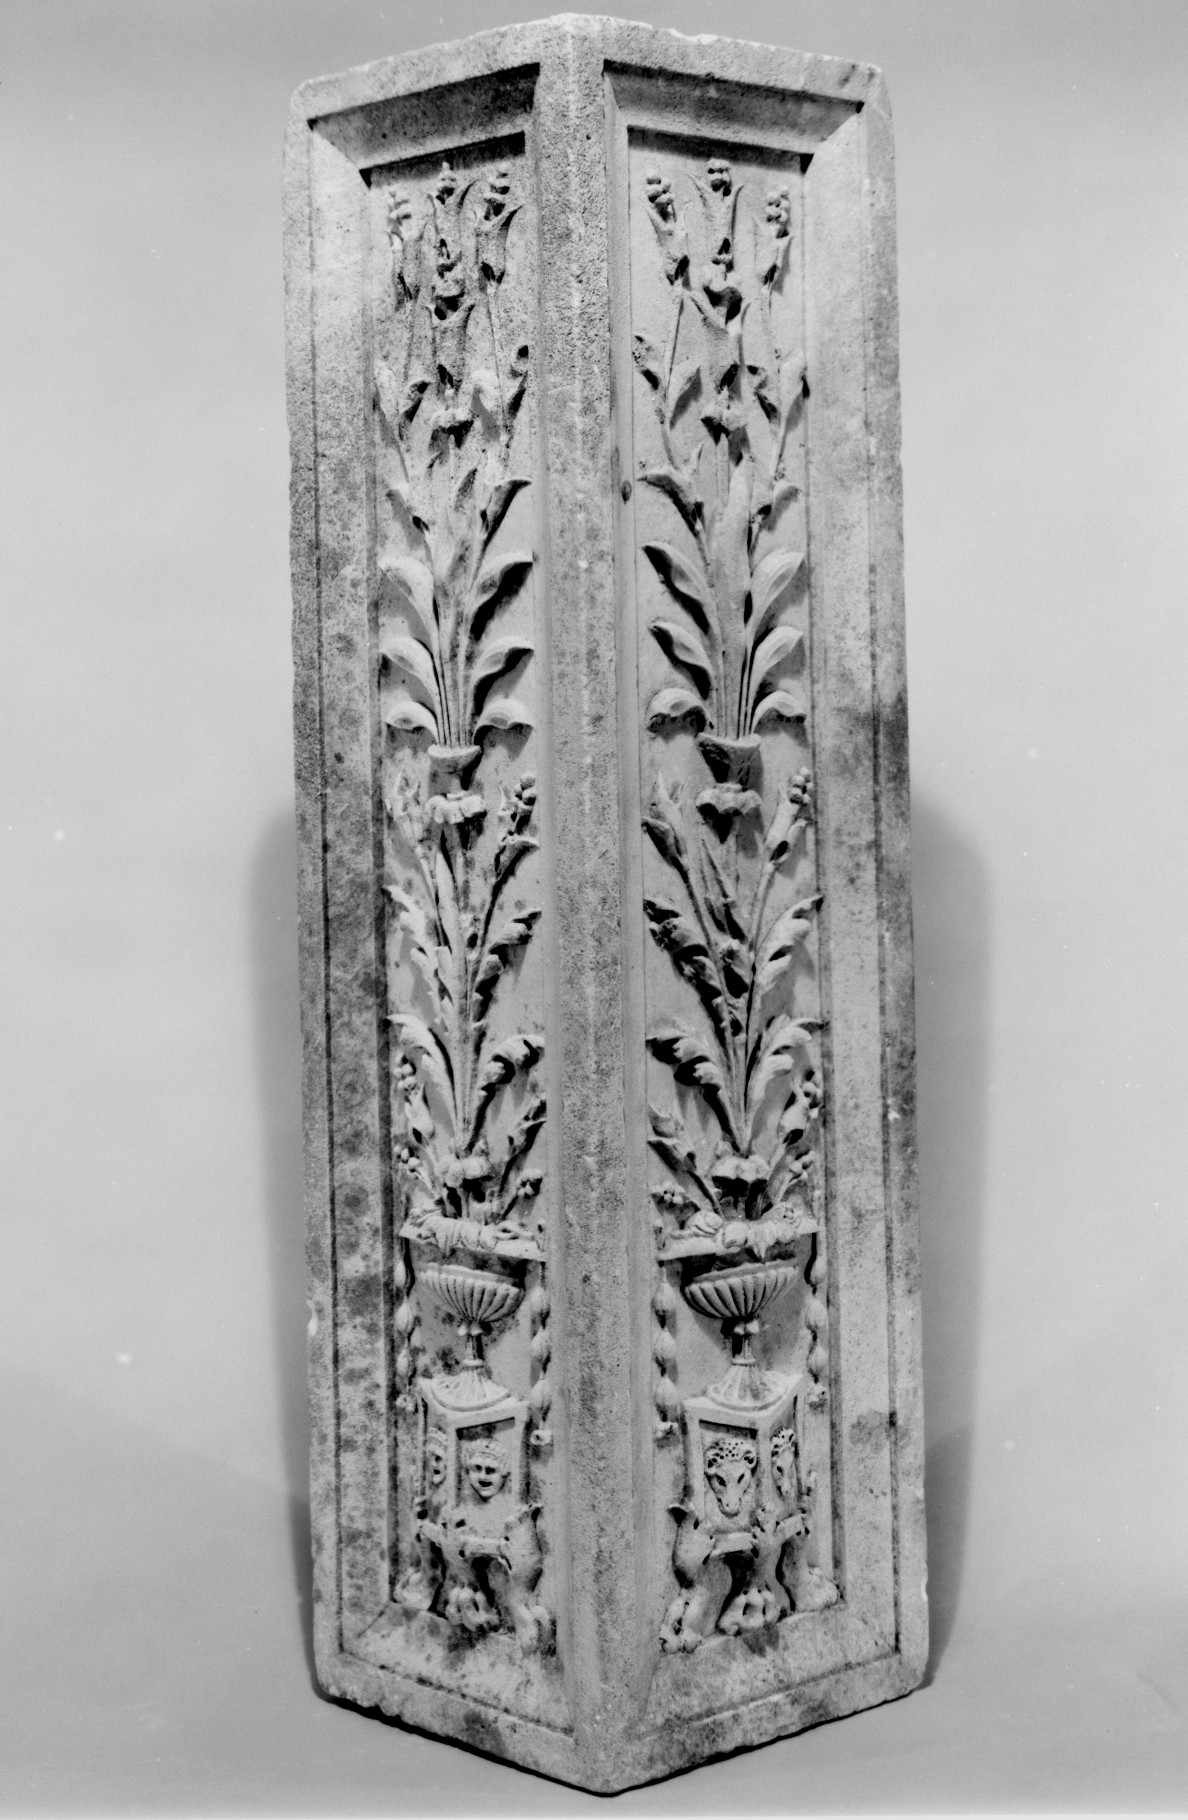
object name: balcony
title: Cantoria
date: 1501-1525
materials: iron, stone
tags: flowers